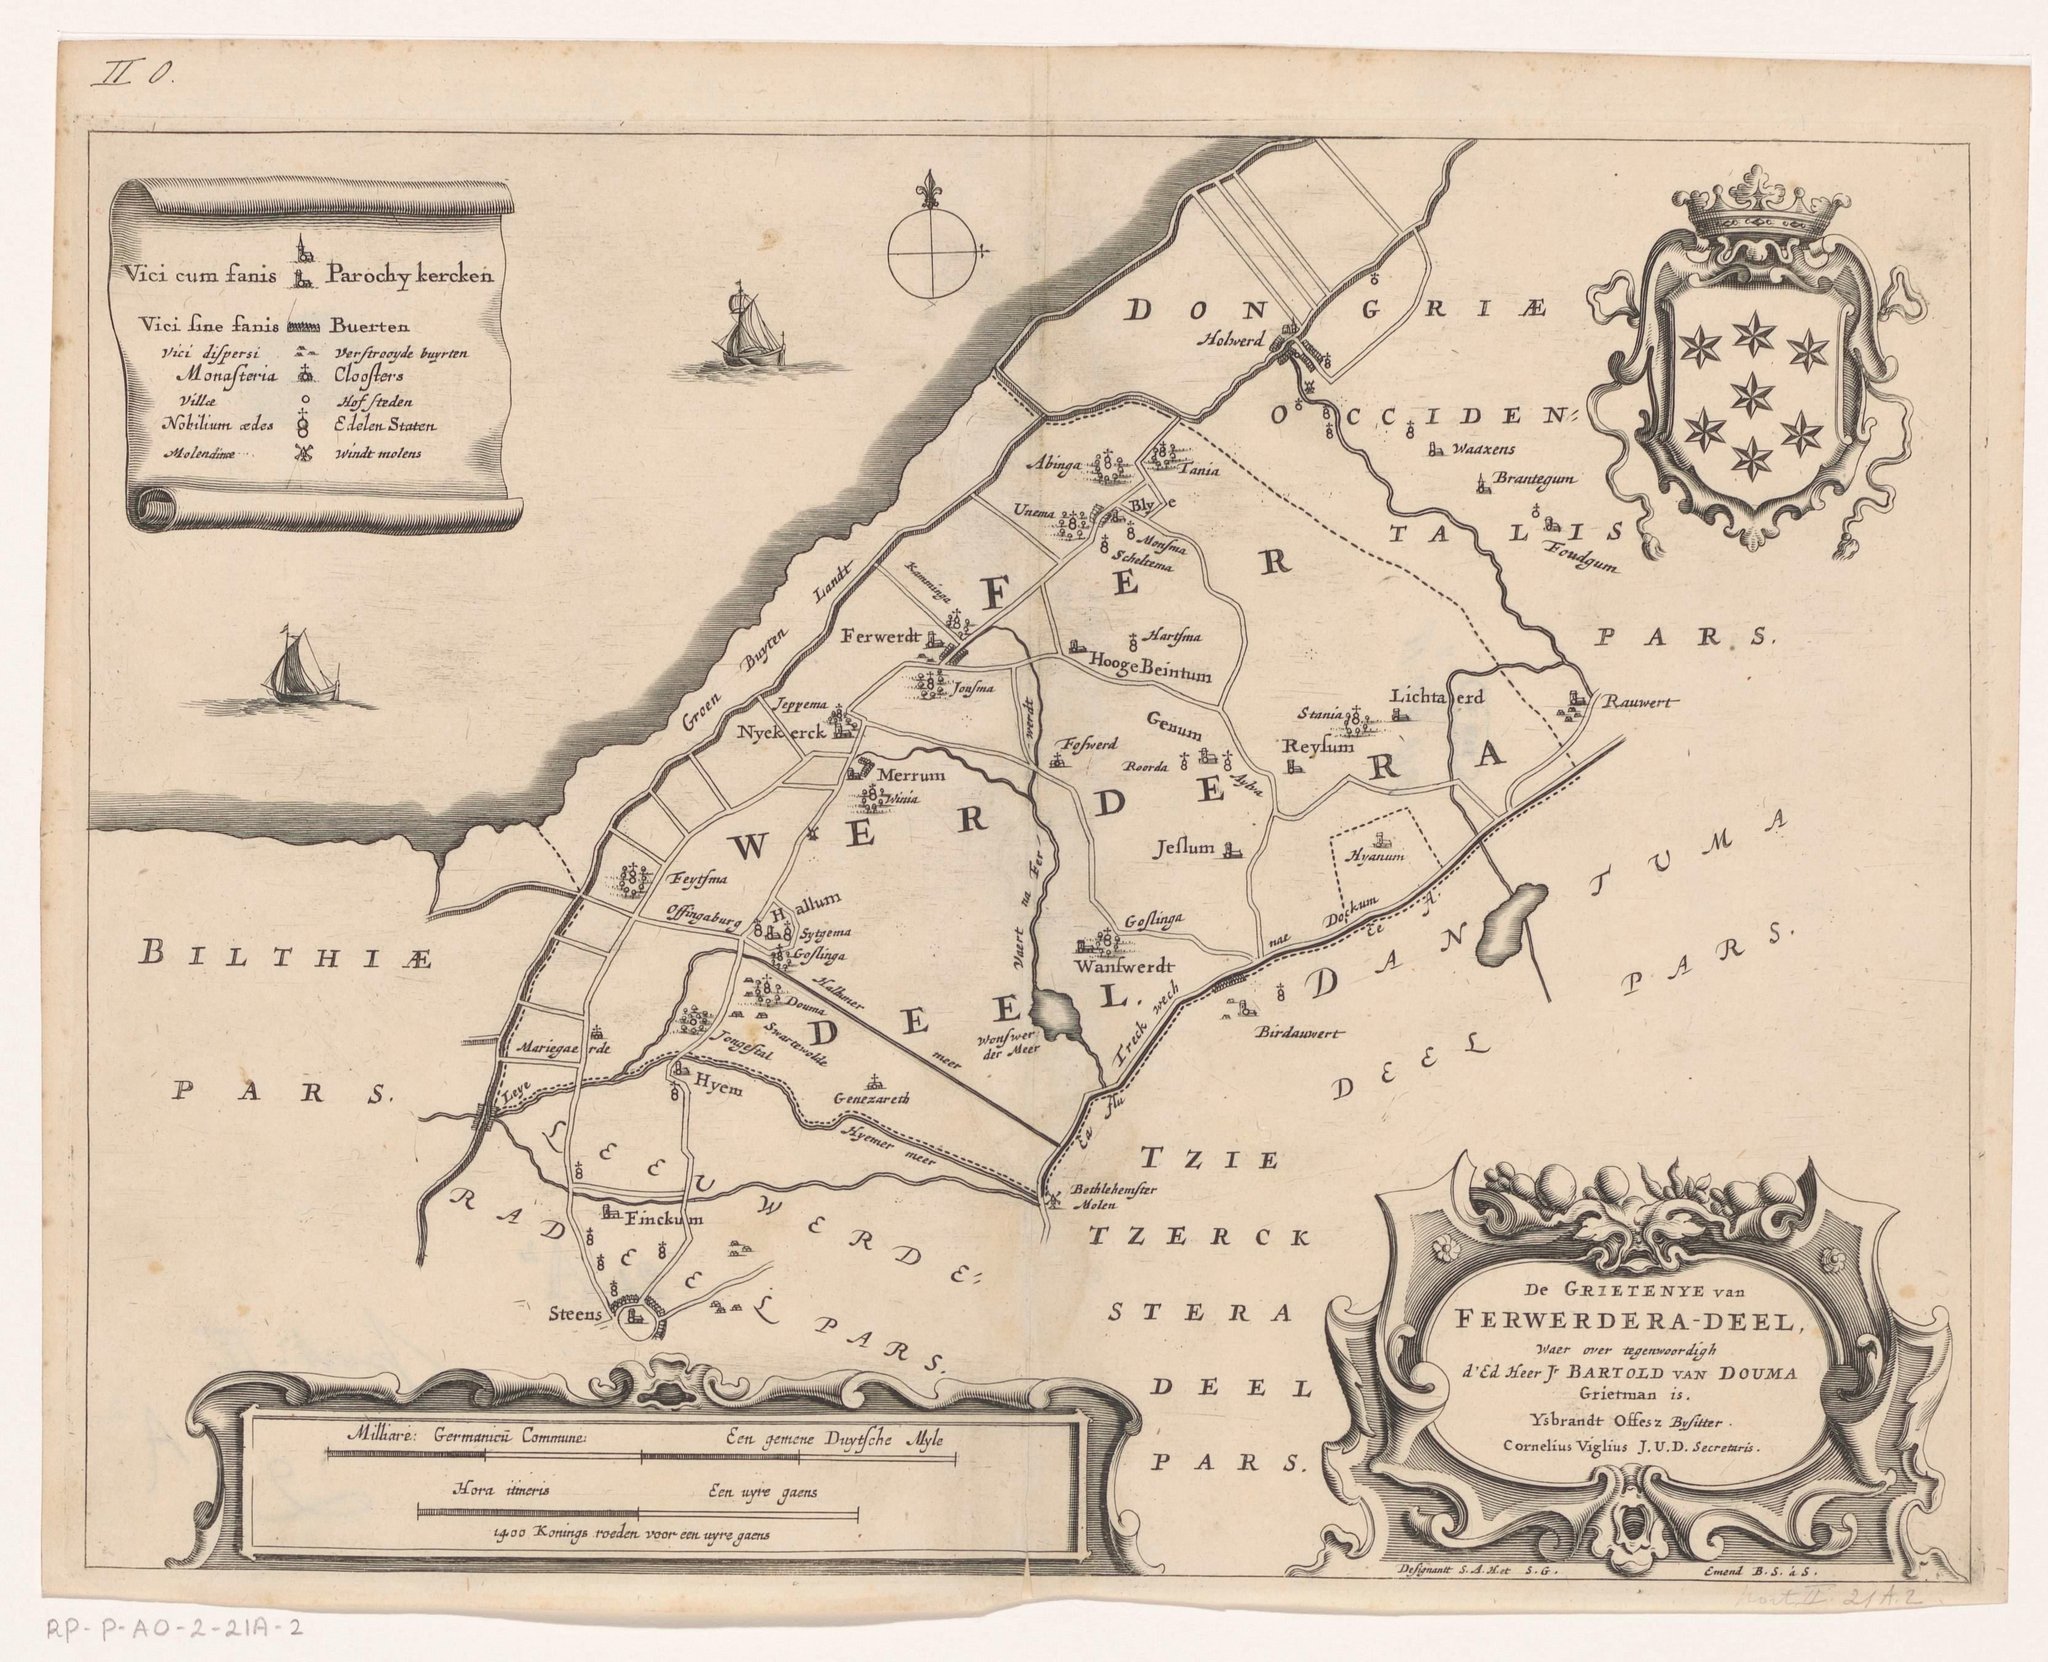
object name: map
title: Kaart van de grietenij Ferwerderadeel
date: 1664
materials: paper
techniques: engraving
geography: friesland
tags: coat of arms (as symbol of the state, etc.), maps of separate countries or regions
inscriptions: collector's mark: Lugt 2228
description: Linksboven legenda, linksonder twee schaalstokken: Milliare: Germanicu commune / Een gemene Duytsche myle, Hora itineris / Een uyre gaens - 1400 konings roeden voor een uyre gaens. Rechtsboven het wapen van Ferwerderadeel, rechtsonder cartouche met titel en bestuurlijke informatie over de grietenij.